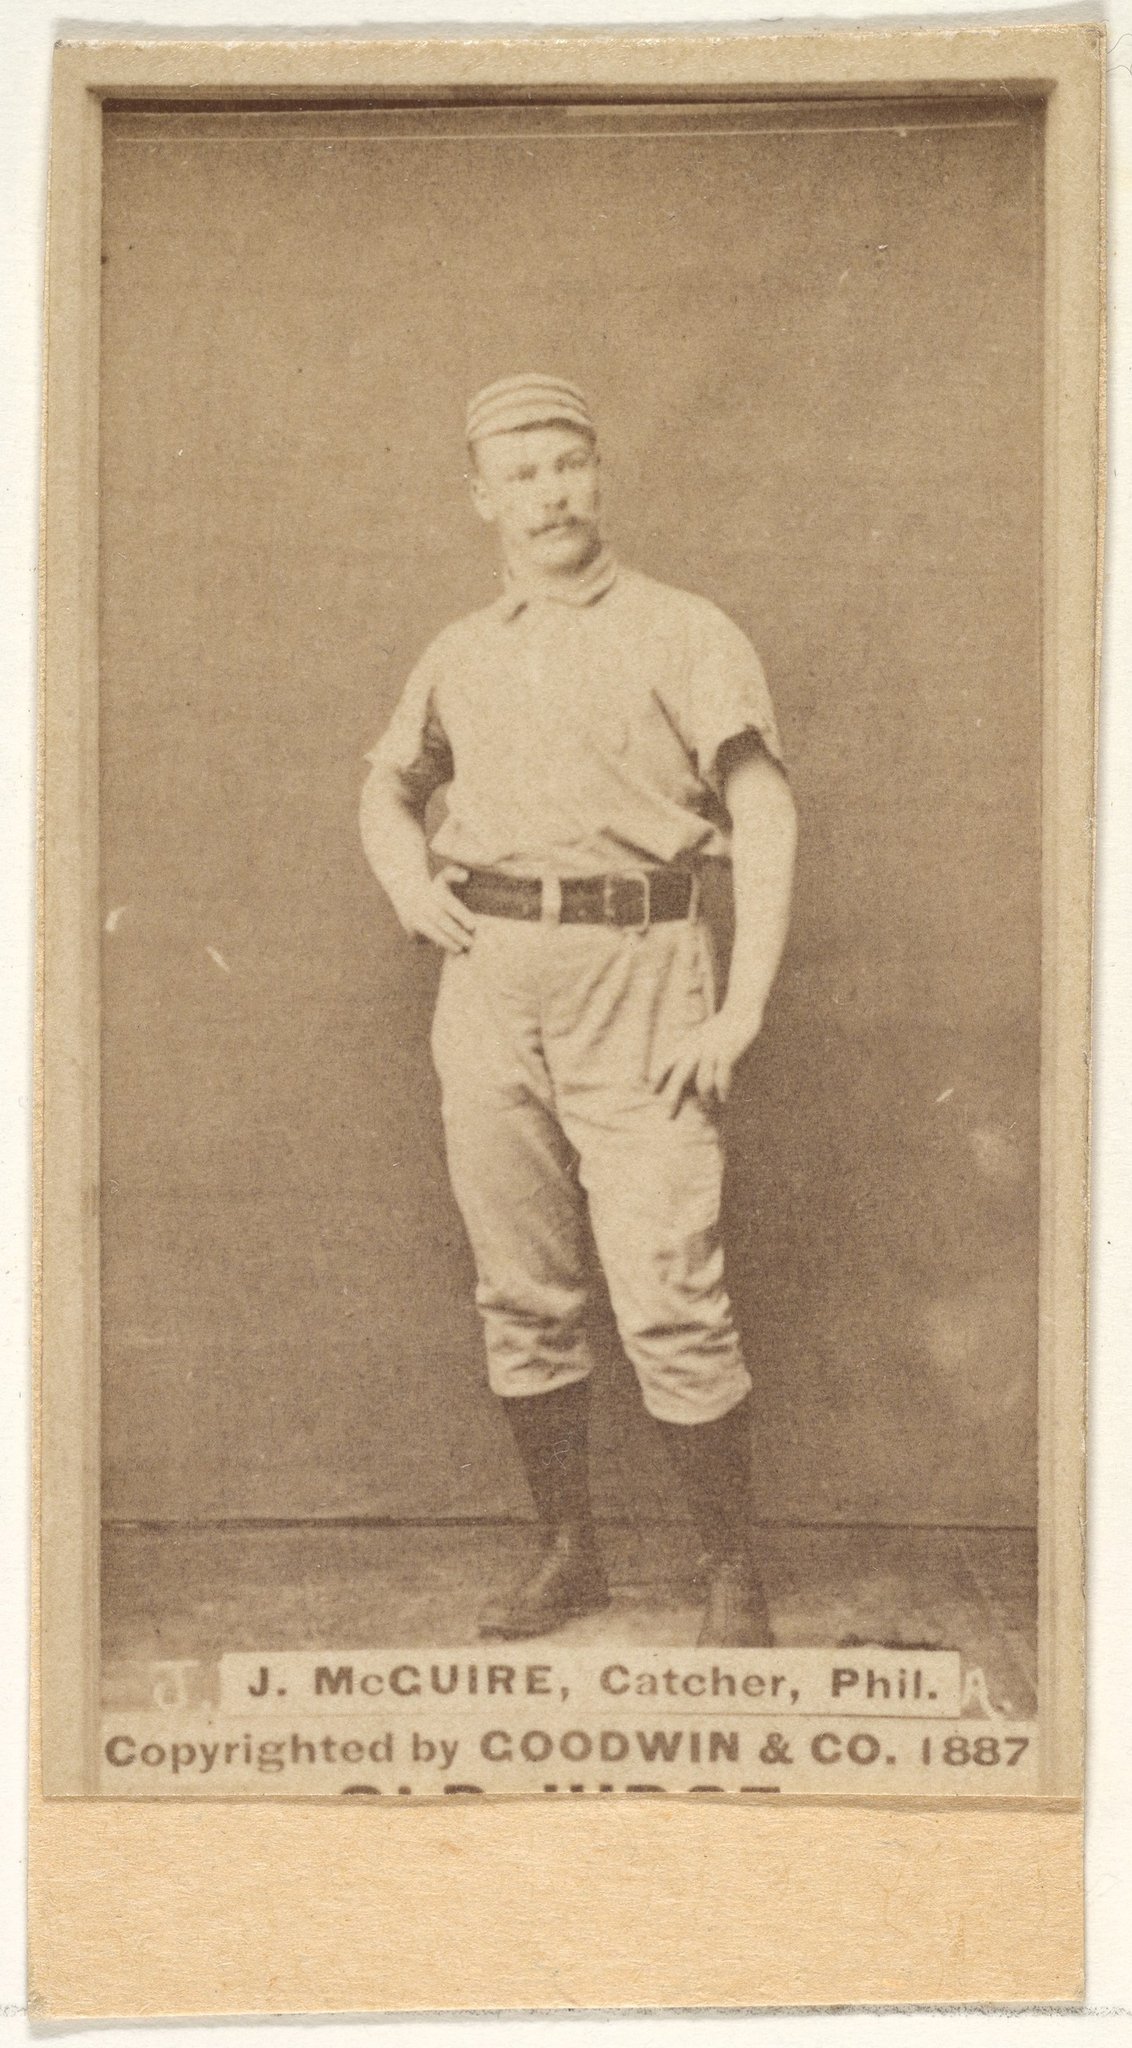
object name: baseball card, photograph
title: James Thomas "Deacon" McGuire, Catcher, Philadelphia, from the Old Judge series (N172) for Old Judge Cigarettes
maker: goodwin & company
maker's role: publisher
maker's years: 1850-1950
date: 1887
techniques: albumen silver print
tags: men,portraits,baseball,athletes